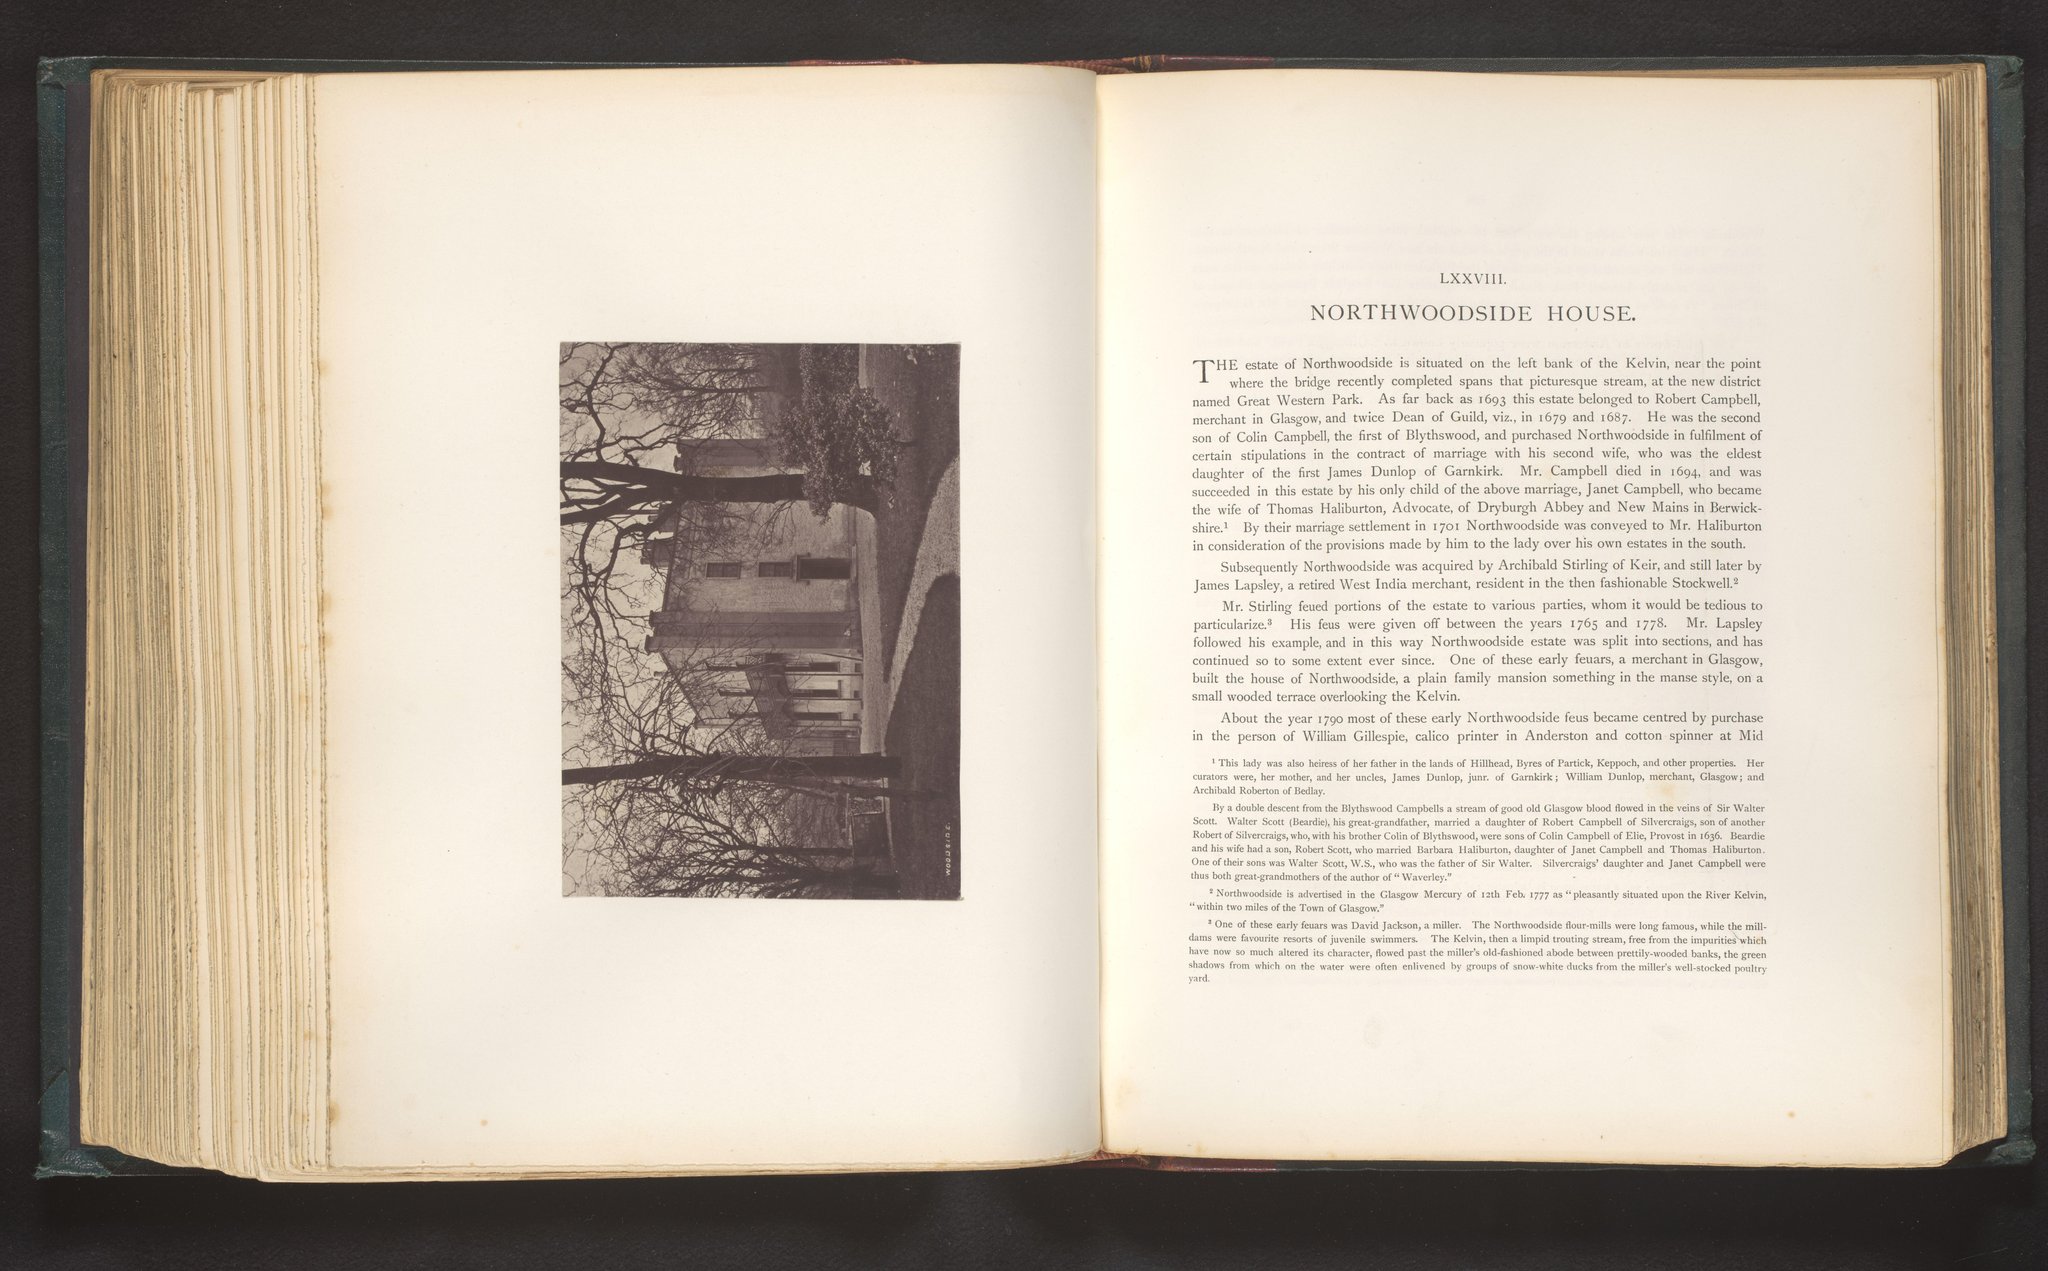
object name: photograph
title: Northwoodside House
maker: thomas annan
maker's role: fotograaf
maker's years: 1829-1887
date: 1868-1878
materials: paper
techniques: carbon print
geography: glasgow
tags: rural housing, e.g. country-house, villa, cottage, façade (of house or building)